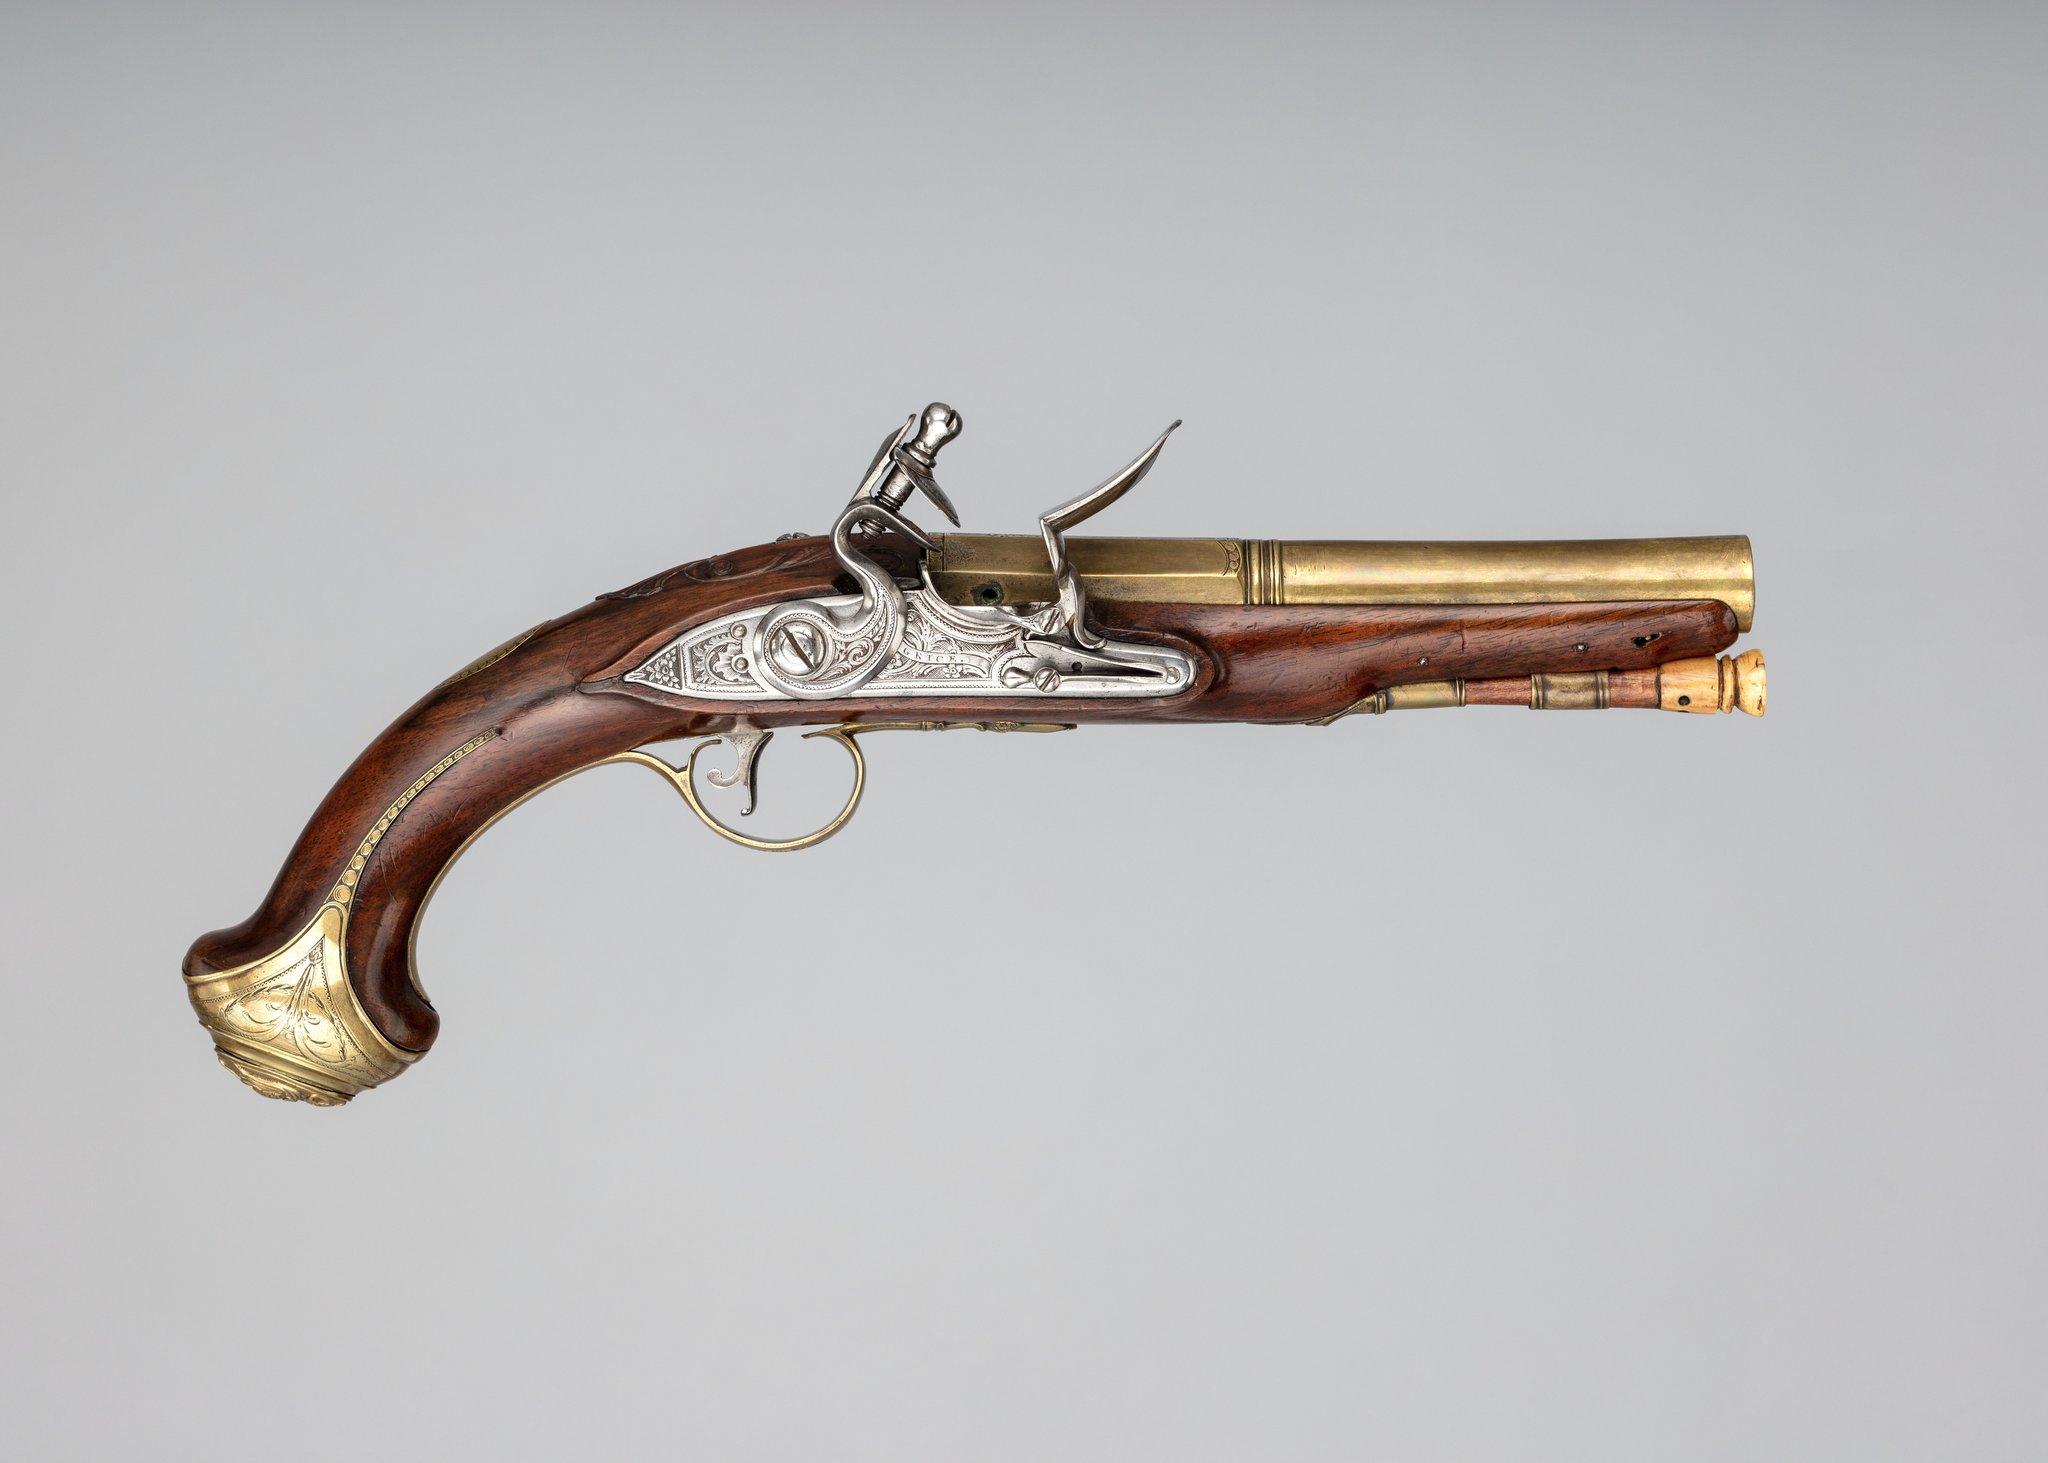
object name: flintlock pistol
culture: british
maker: james grice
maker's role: gunsmith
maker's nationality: british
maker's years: 1790-1800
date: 1770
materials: brass, horn, steel, wood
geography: england